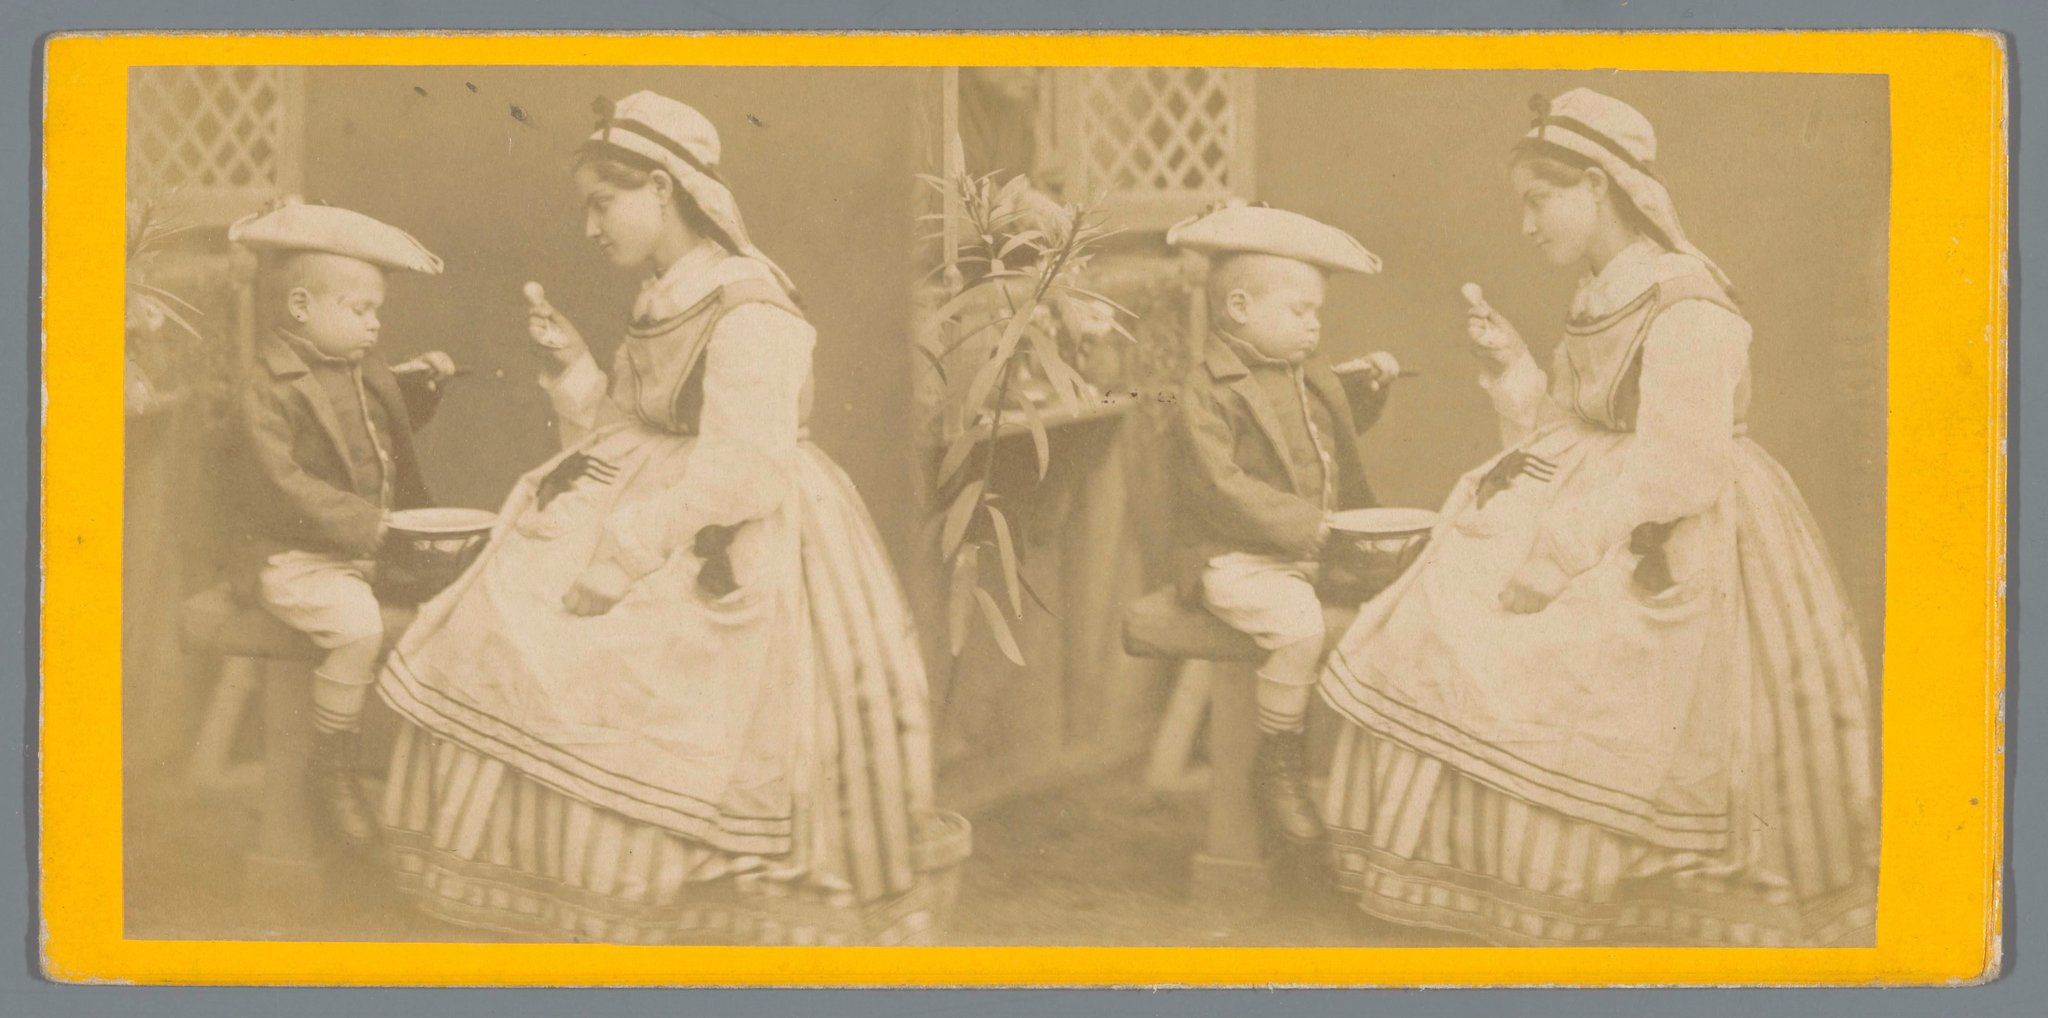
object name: stereograph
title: Vrouw en een jongen met een hoed op eten uit een kom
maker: Anonymous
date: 1850-1880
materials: cardboard, photographic support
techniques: albumen print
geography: europe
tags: eating, europe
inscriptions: number: ‘25’